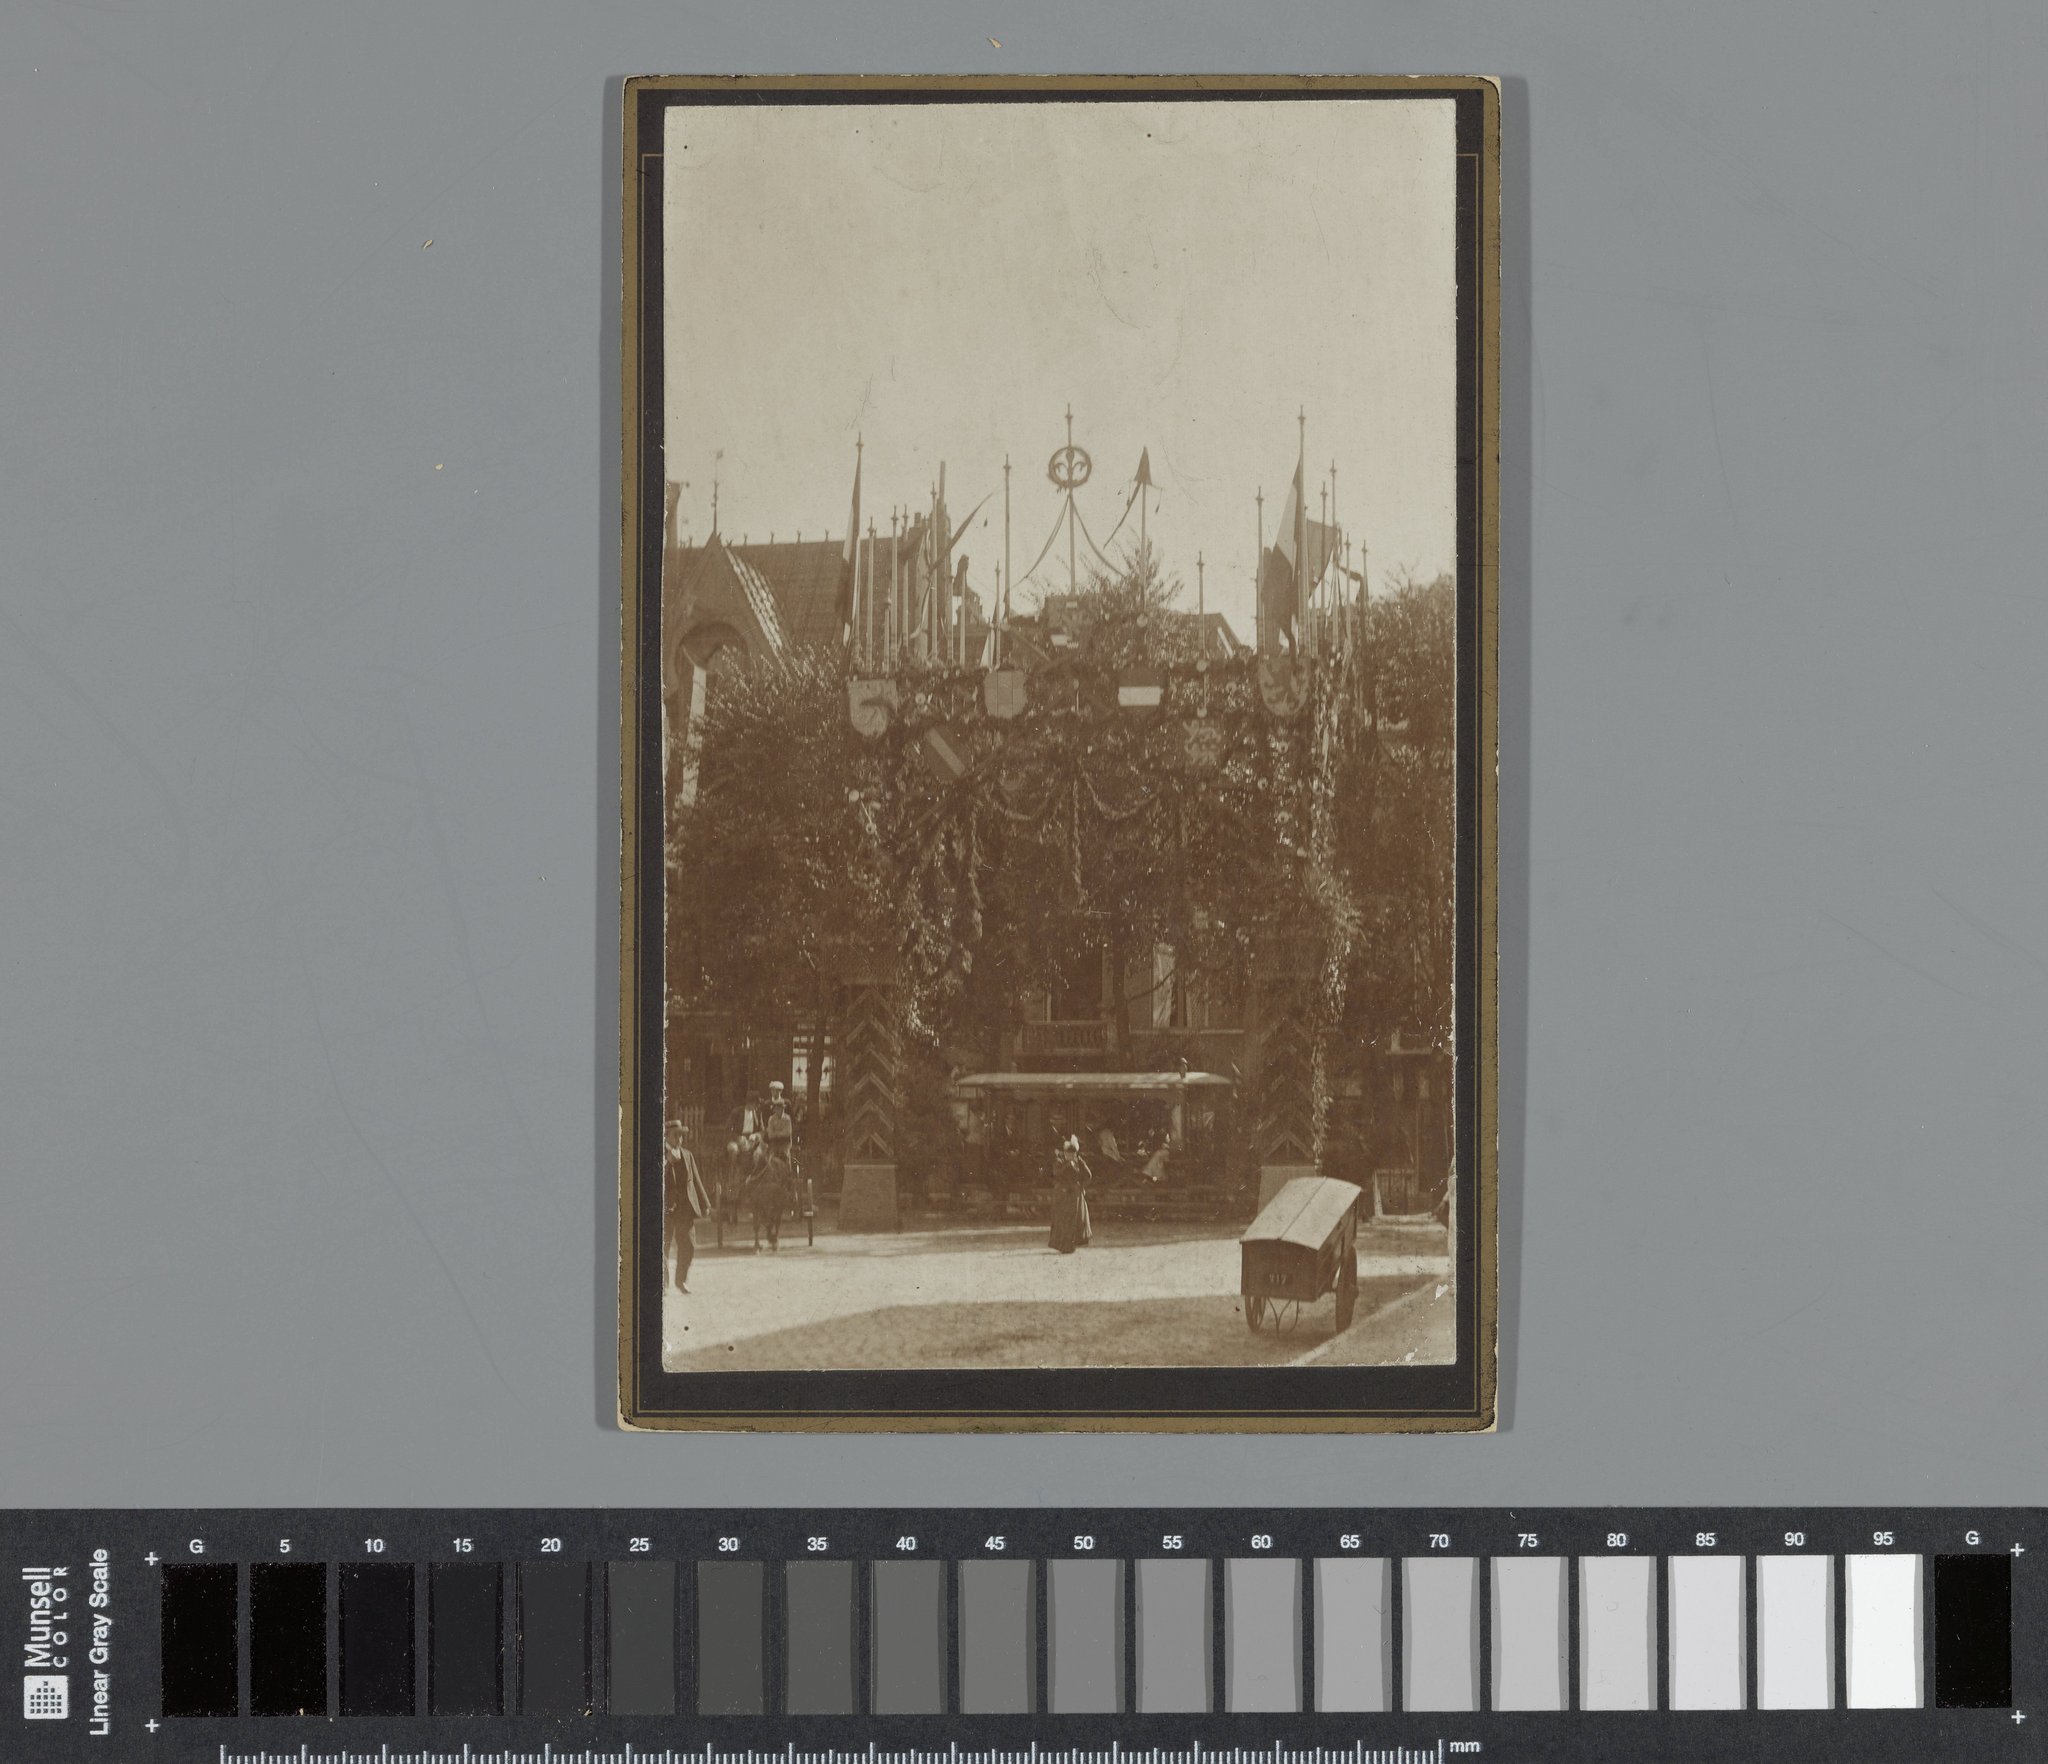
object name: photograph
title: Versieringen in Leeuwarden (?) ter gelegenheid van de inhuldiging van koningin Wilhelmina, 1898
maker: Anonymous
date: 1898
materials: cardboard, paper, photographic support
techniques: collodion silver print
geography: leeuwarden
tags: the hague, wilhelmina of the netherlands, decorations, honours (as symbols of the state, etc.), amsterdam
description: Versieringen ter gelegenheid van de inhuldiging van koningin Wilhelmina op 6 september 1898. Mogelijk in Leeuwarden.